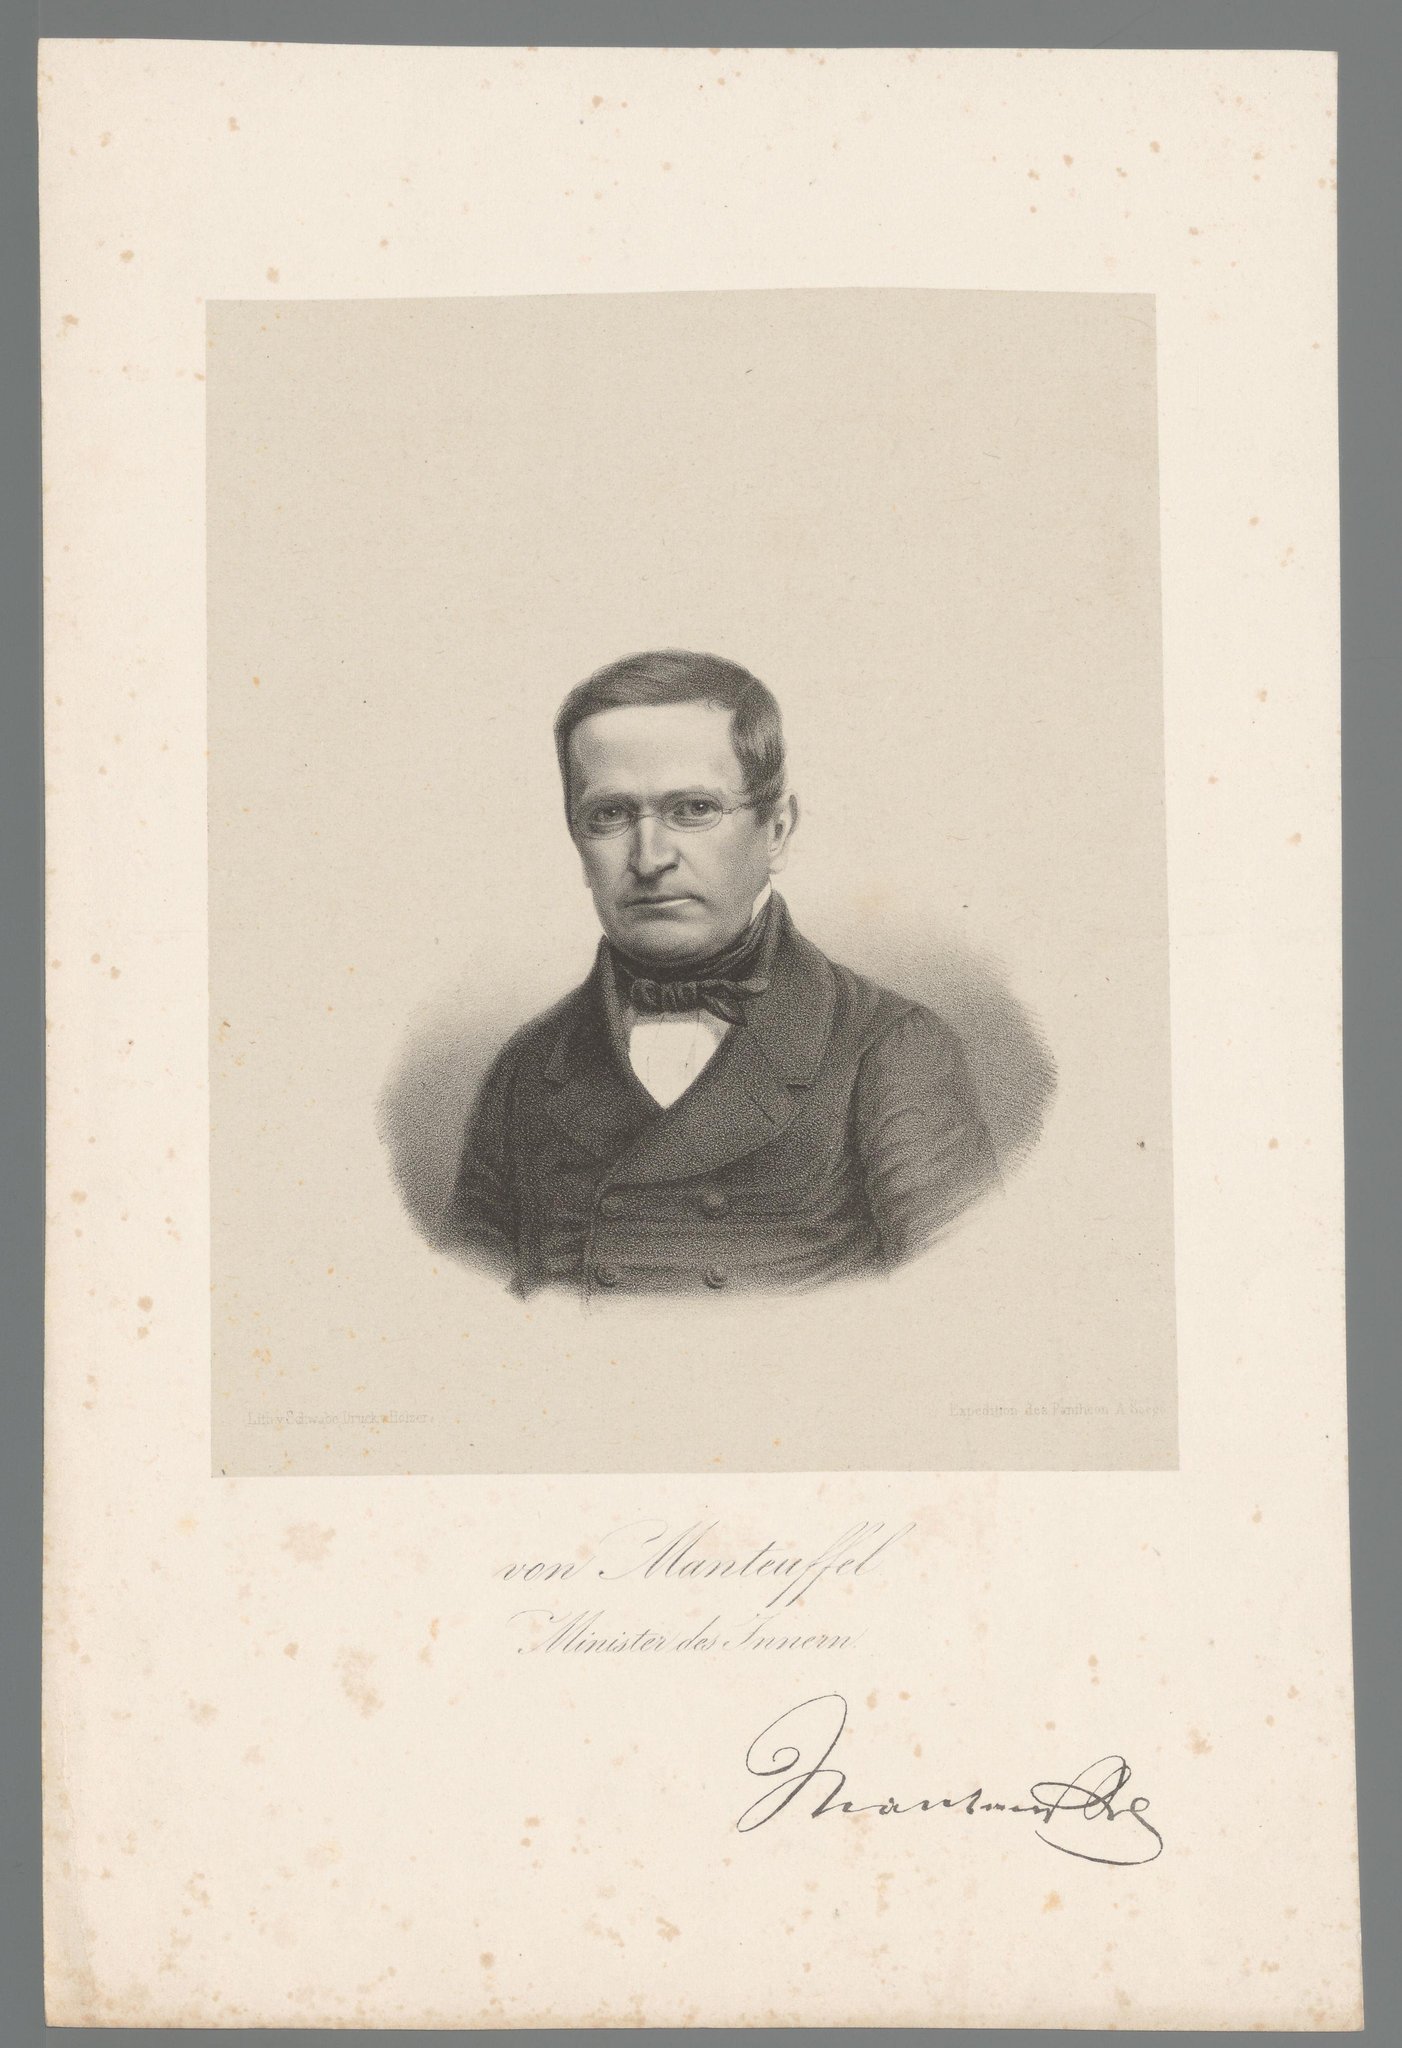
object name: print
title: Portret van Otto von Manteuffel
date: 1830-1863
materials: paper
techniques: lithograph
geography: berlin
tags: eyeglasses, spectacles, adult man, historical persons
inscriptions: collector's mark: Lugt 2228